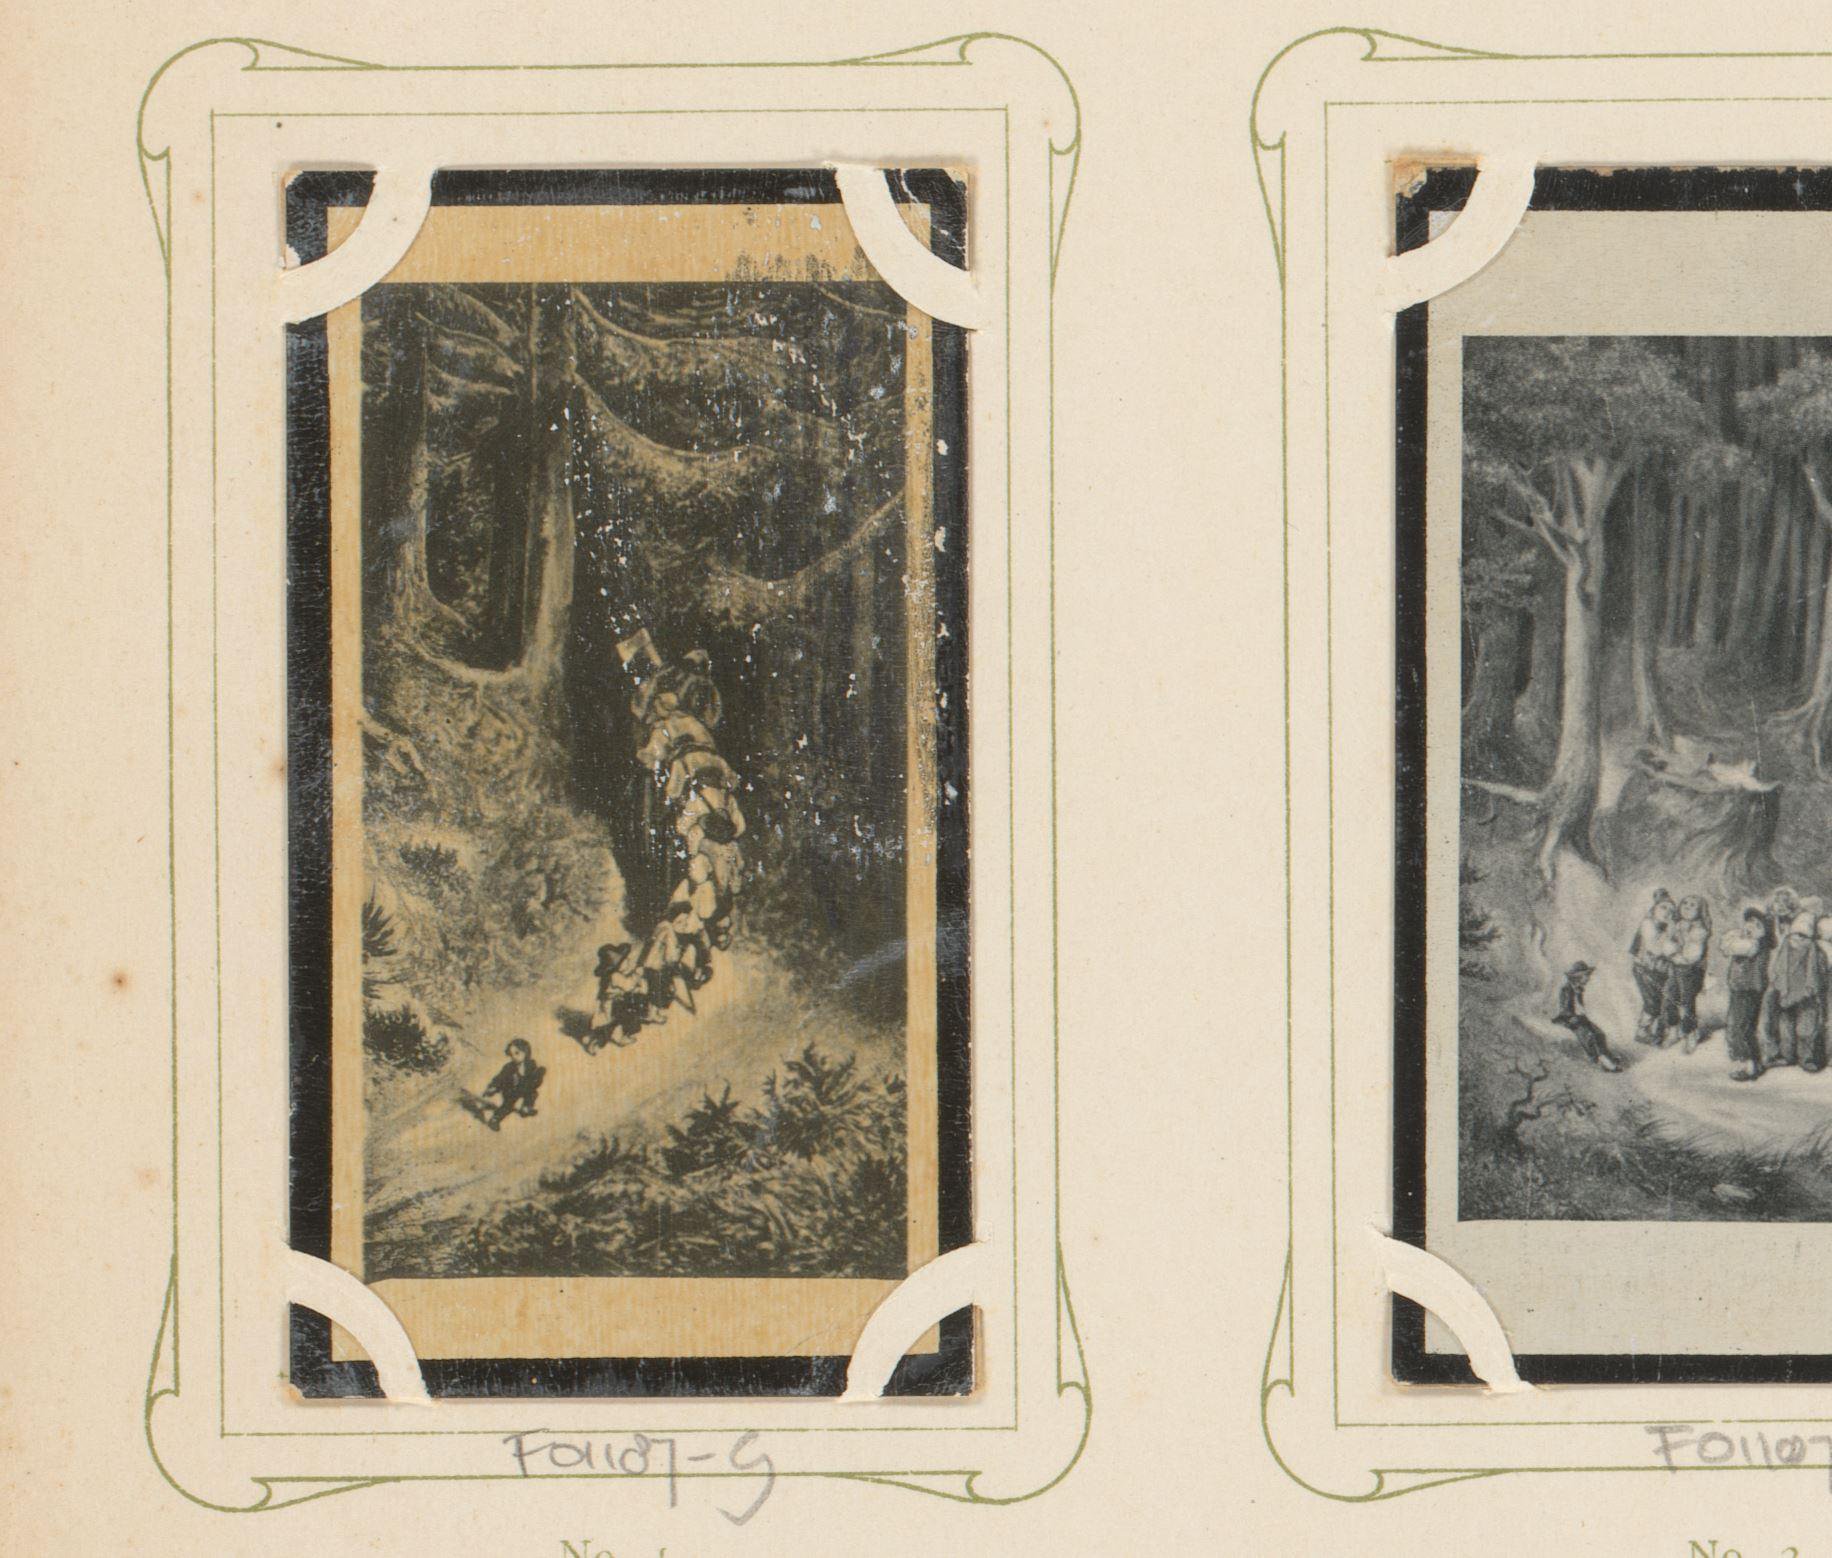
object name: album leaf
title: Reproductie van een tekening van Klein Duimpje die broodkruimels strooit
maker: Anonymous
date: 1905-1906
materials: paper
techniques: photograph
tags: tales and fairy tales: little thumbling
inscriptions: inscription: ‘No. 1./ Klein Duimpje strooit broodkruimels.’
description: Deze prent maakt deel uit van een album.